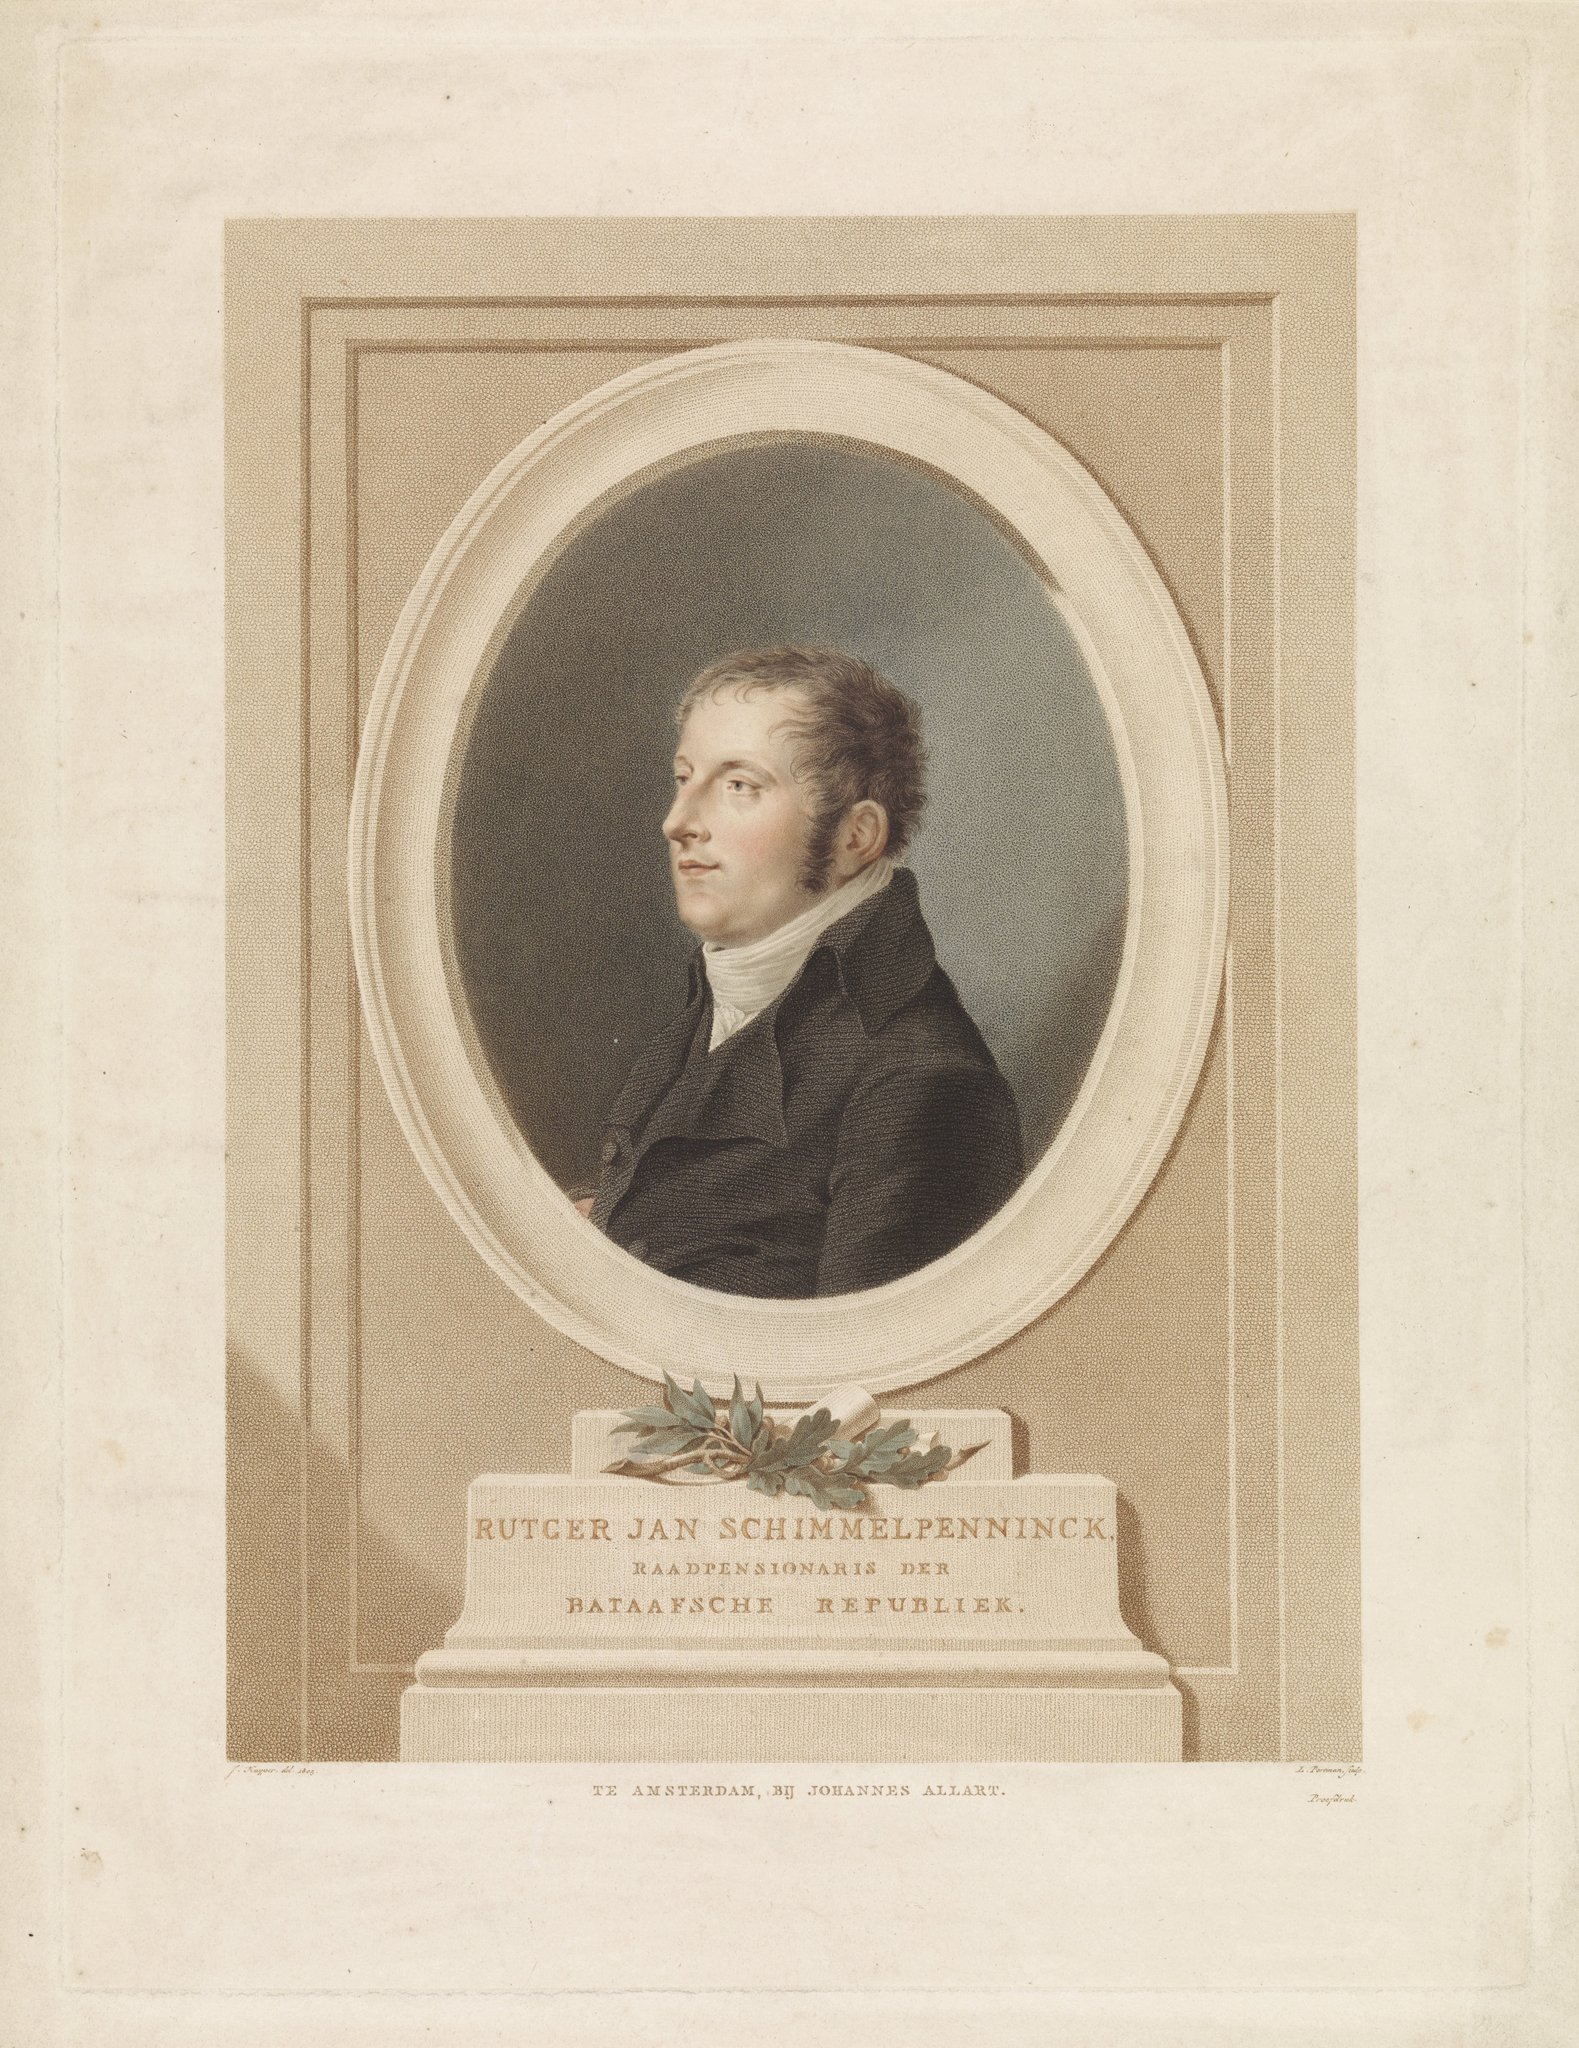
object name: print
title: Portret van Rutger Jan Schimmelpenninck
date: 1805-1817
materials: paper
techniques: printing, engraving, hand coloring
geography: amsterdam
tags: deventer, amsterdam, rutger jan schimmelpenninck (1761-1825), historical persons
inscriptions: collector's mark: Lugt 2228, collector's mark: Lugt 2760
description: Portret van Rutger Jan Schimmelpenninck, raadspensionaris van de Bataafse Republiek, in een ovaal. Onder het portret zijn naam en functie in drie regels in het Nederlands.